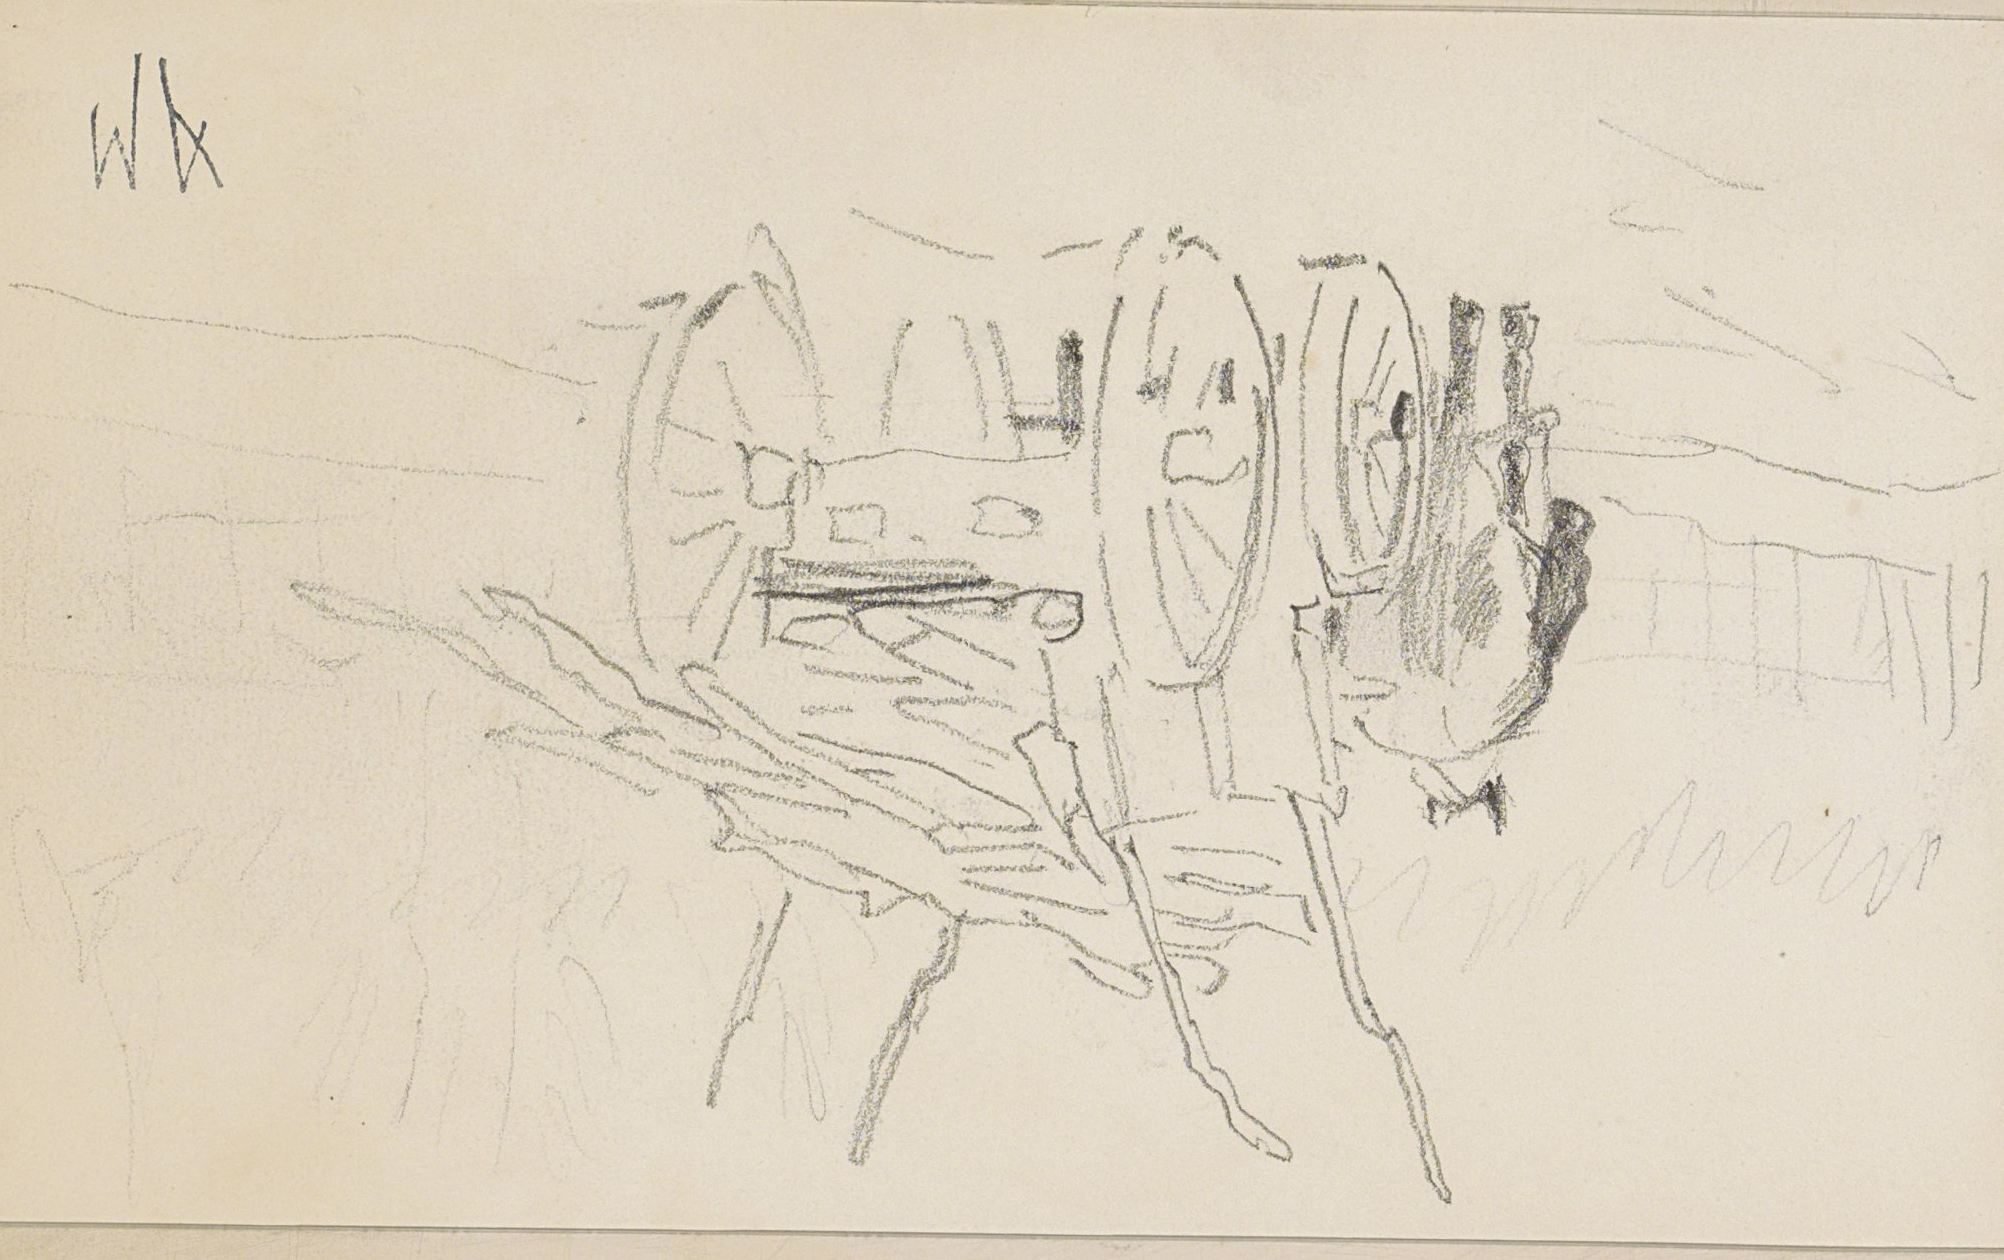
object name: sketchbook leaf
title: Met sprokkelhout beladen paardenkar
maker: anton mauve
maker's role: draughtsman, painter, print maker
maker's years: 1838-1888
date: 1848-1888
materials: paper, pencil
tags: trees (+ branch, stick), (farm) wagon, freight wagon, cart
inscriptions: monogram: ‘AM’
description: Blad 43 verso uit een schetsboek met 44 bladen.